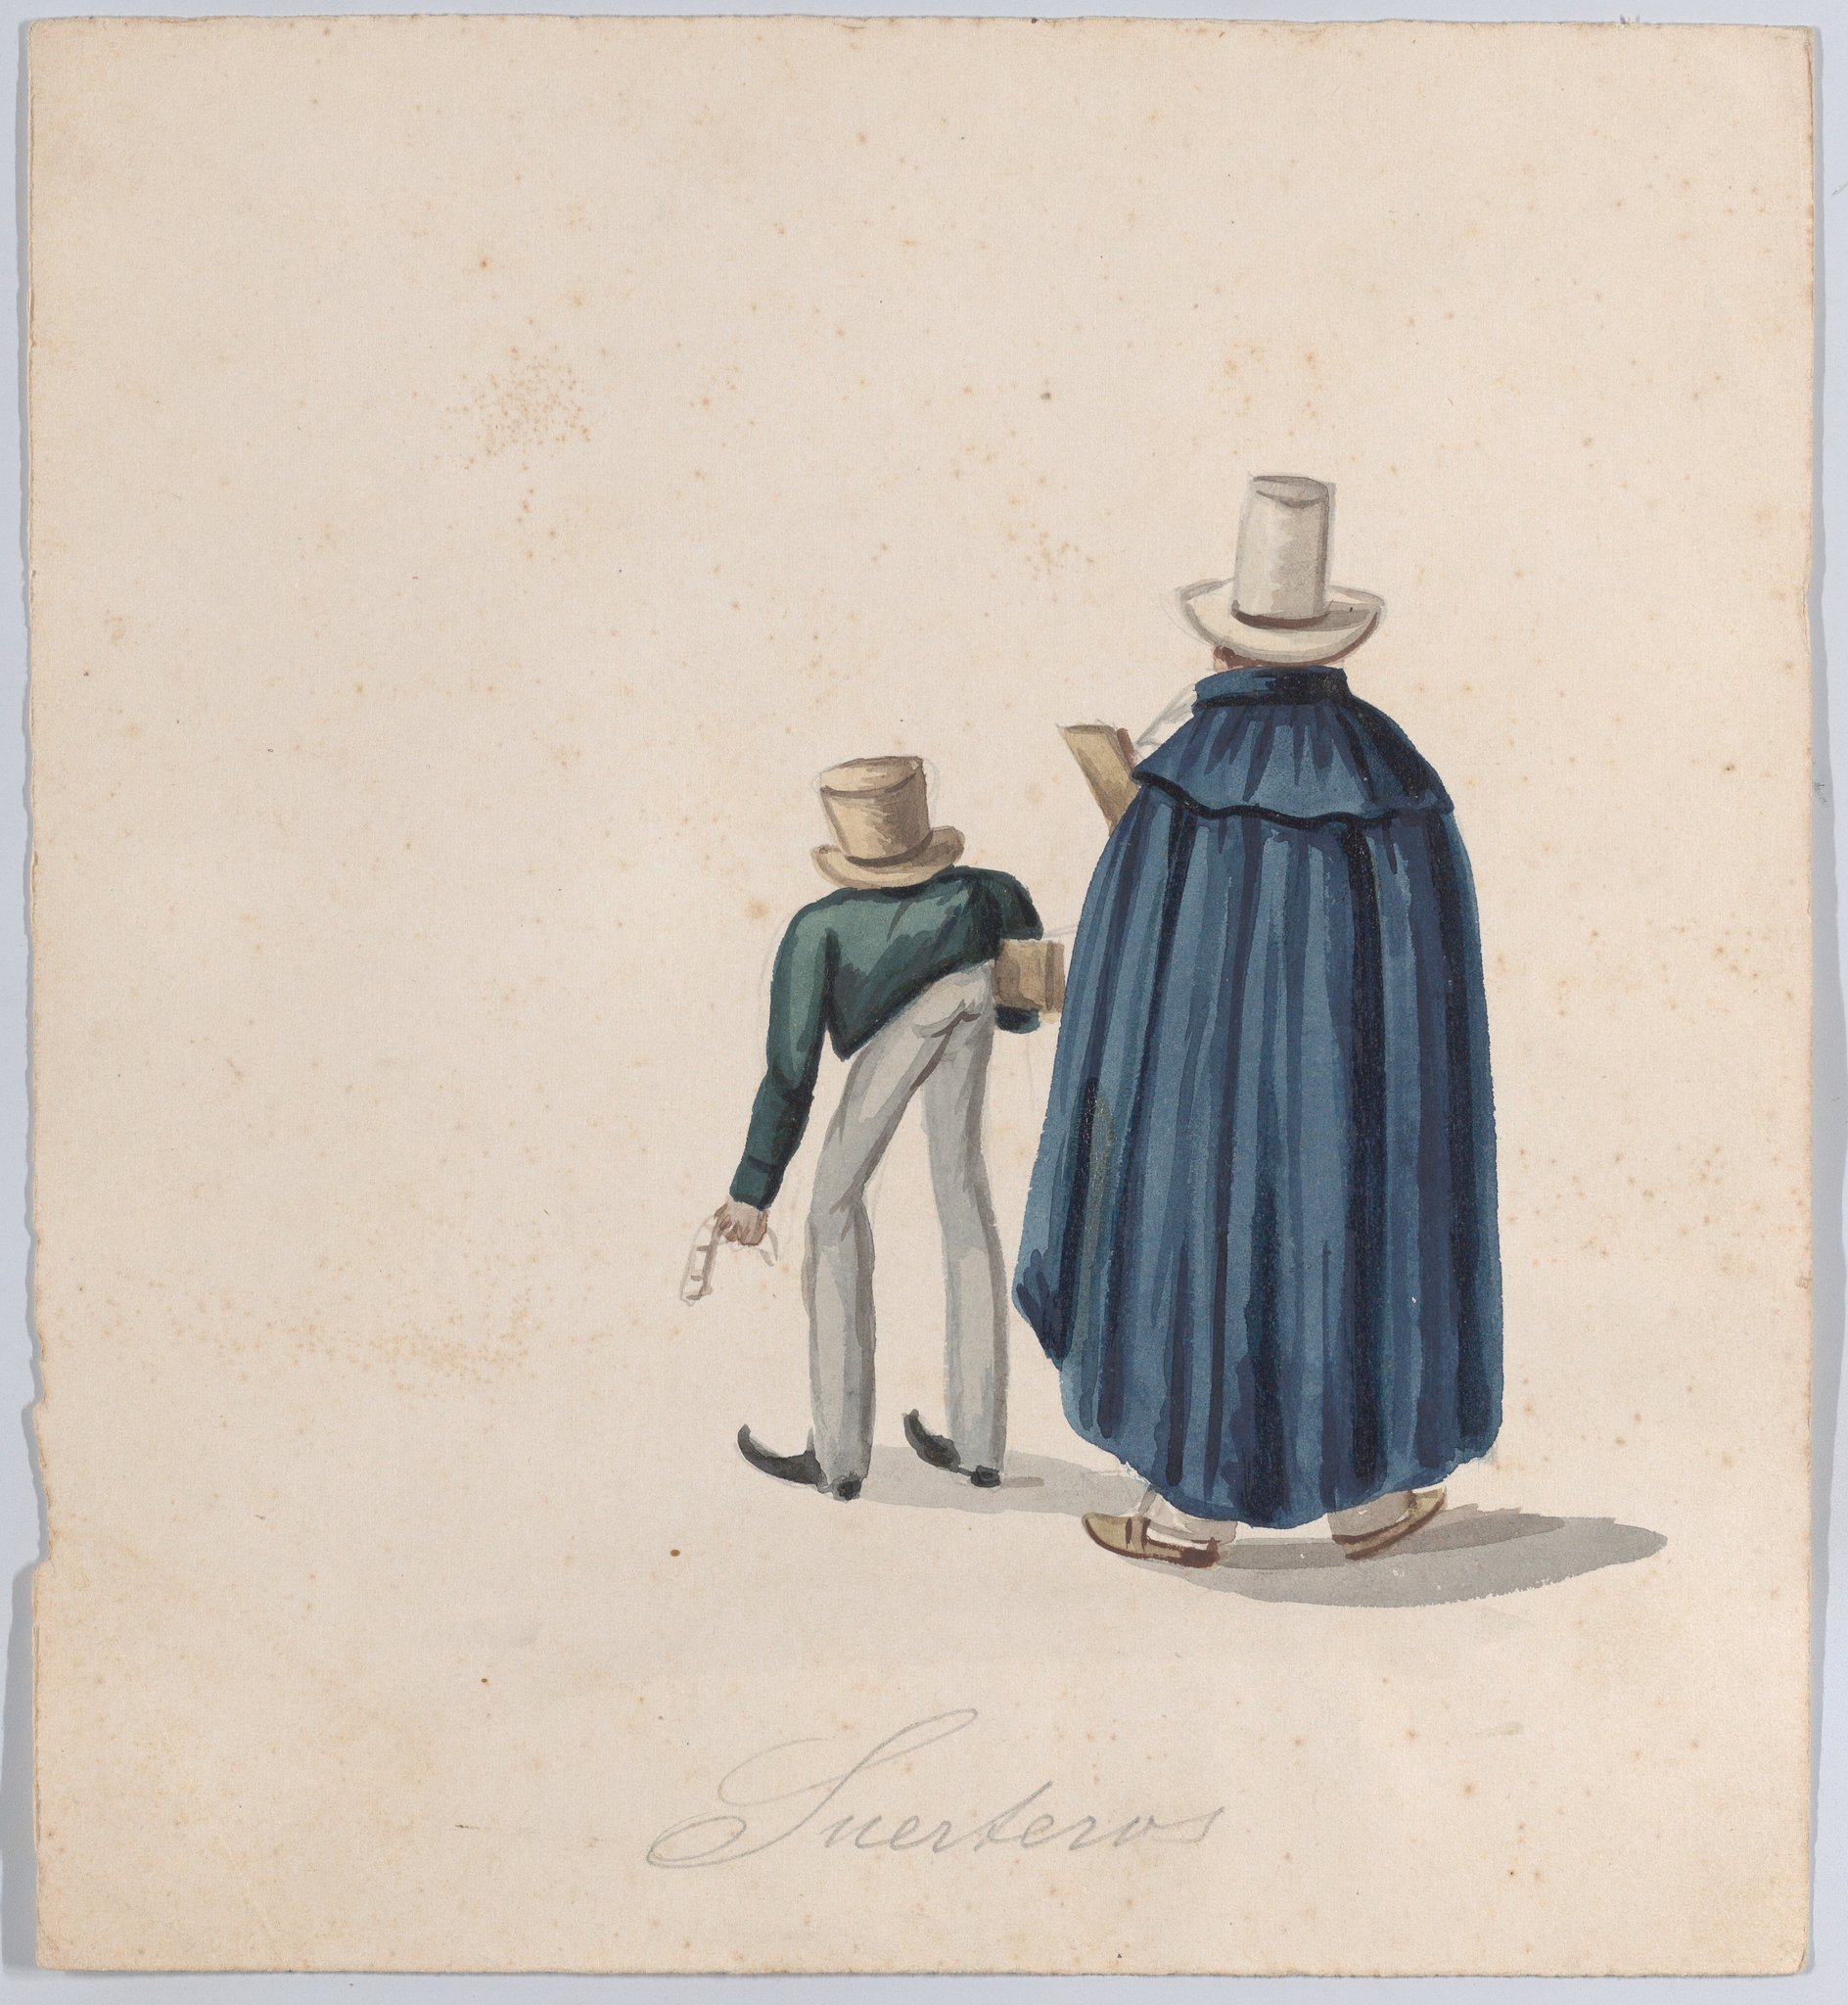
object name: drawing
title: Two fortune tellers (?) wearing top hats viewed from behind, from a group of drawings depicting Peruvian dress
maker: francisco (pancho) fierro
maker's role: artist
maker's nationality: african peruvian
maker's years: 1807-1879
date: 1848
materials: watercolor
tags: men,women